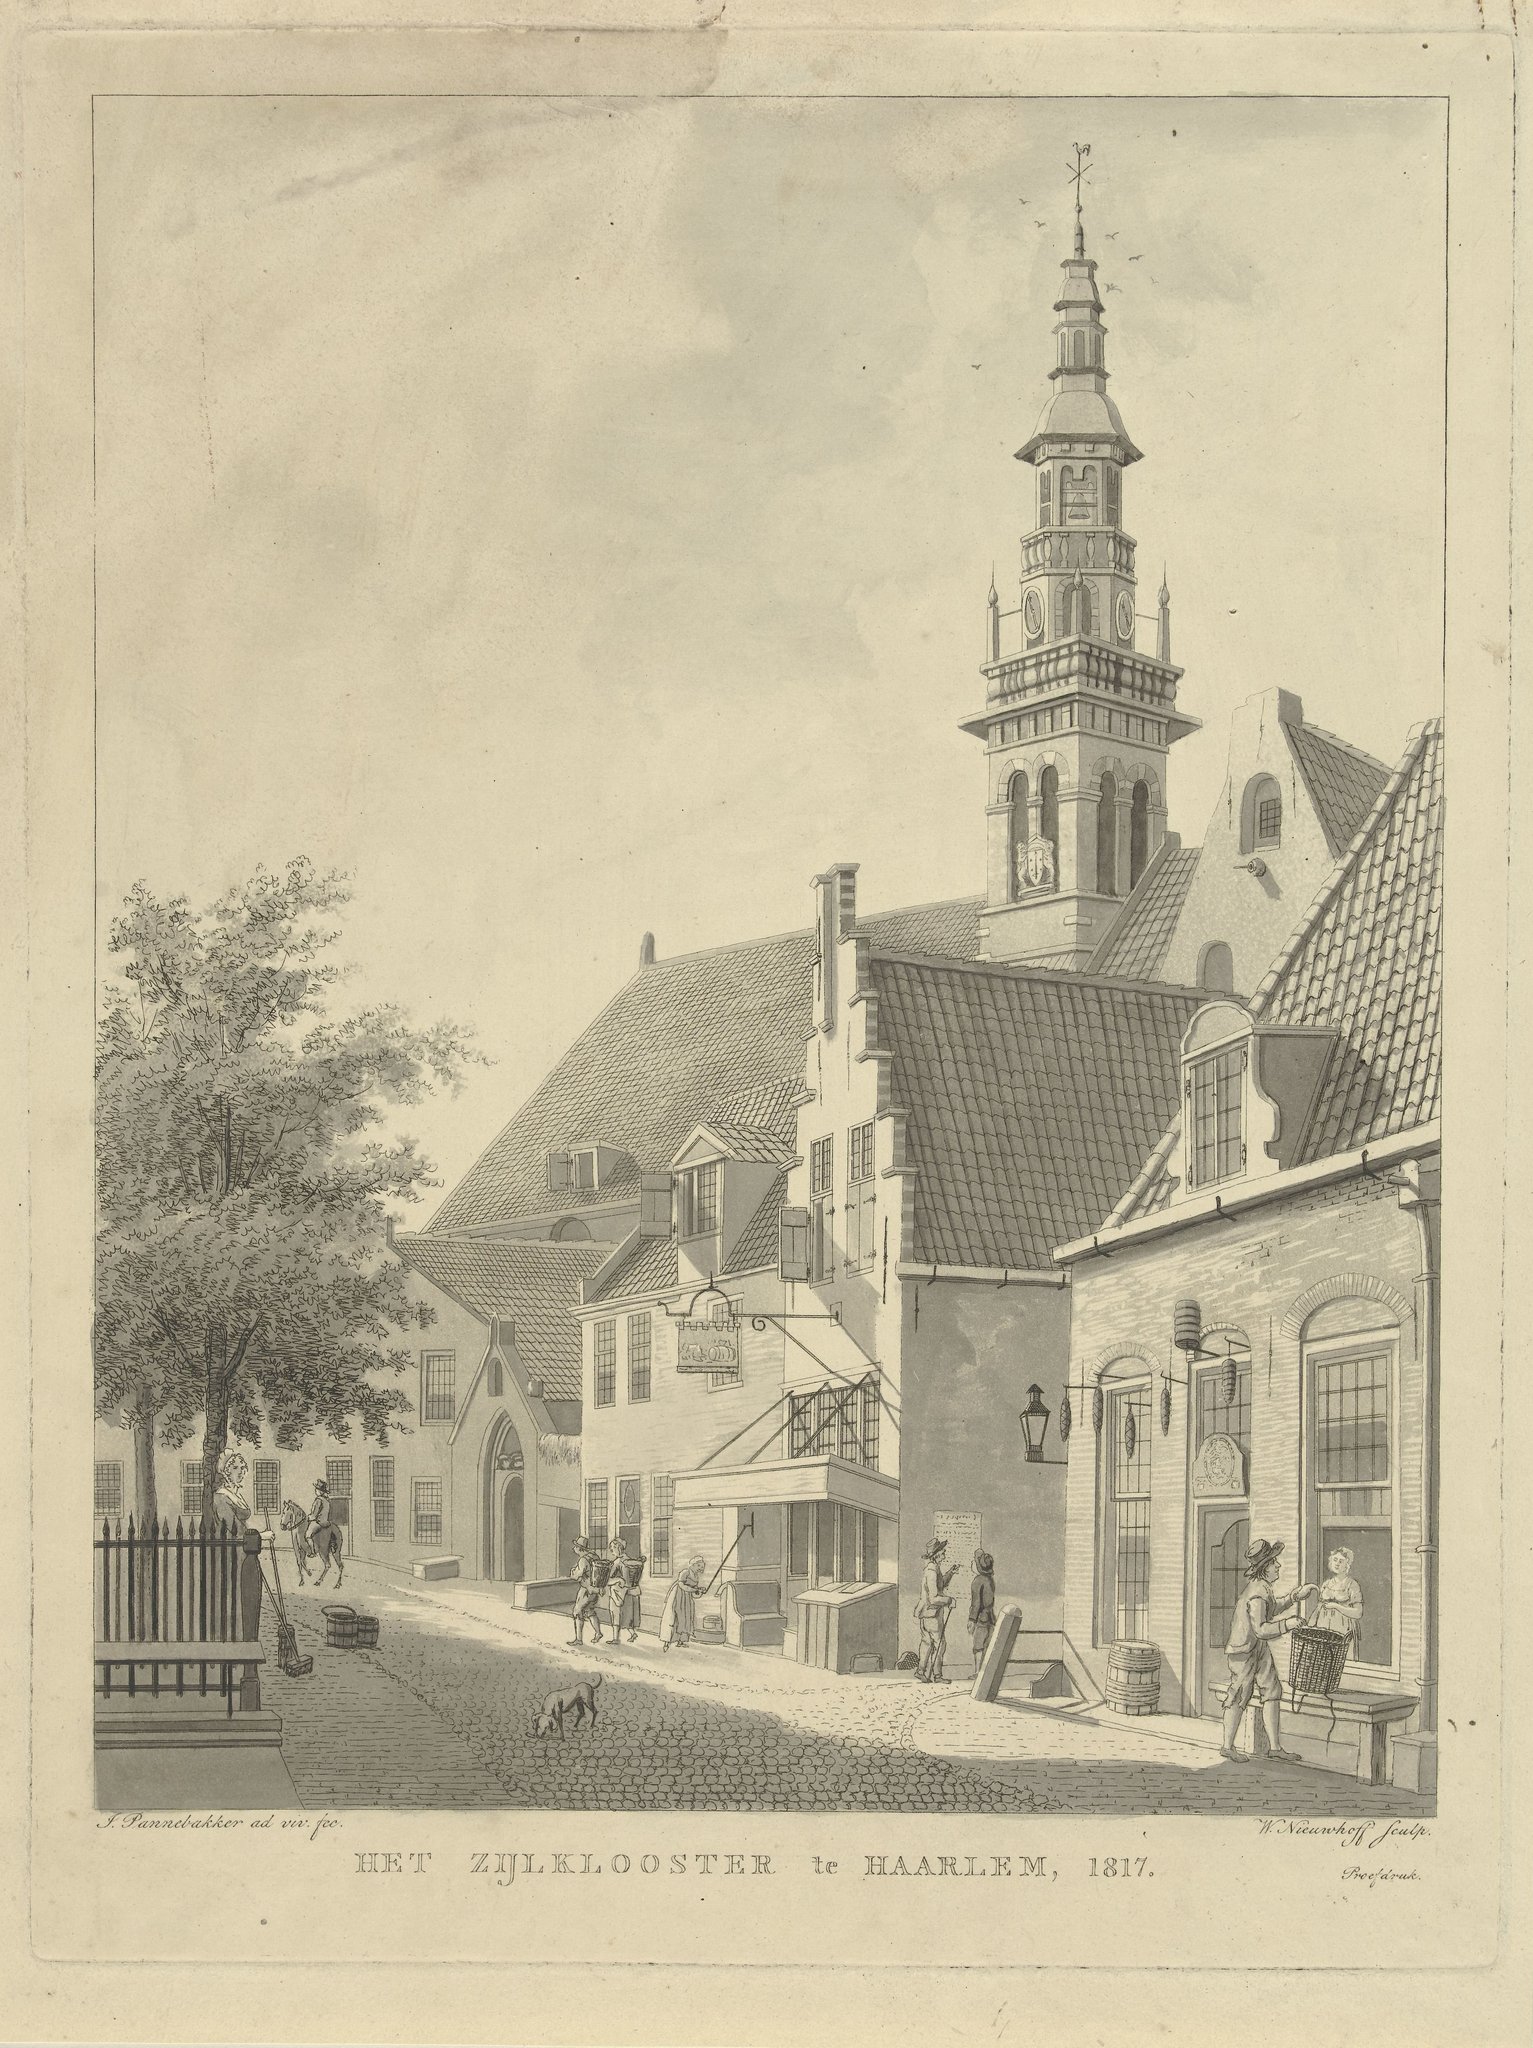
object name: print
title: Het Zijlklooster te Haarlem, 1817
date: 1800-1837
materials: paper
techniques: brush, etching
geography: amsterdam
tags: abbey, monastery, convent ~ roman catholic church, street, dog, haarlem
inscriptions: collector's mark: Lugt 2228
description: Gezicht op de kerk van het Zijlklooster in Haarlem. Daarvoor liggen winkels aan de straat. Op straat lopen mensen, een ruiter en een hond.